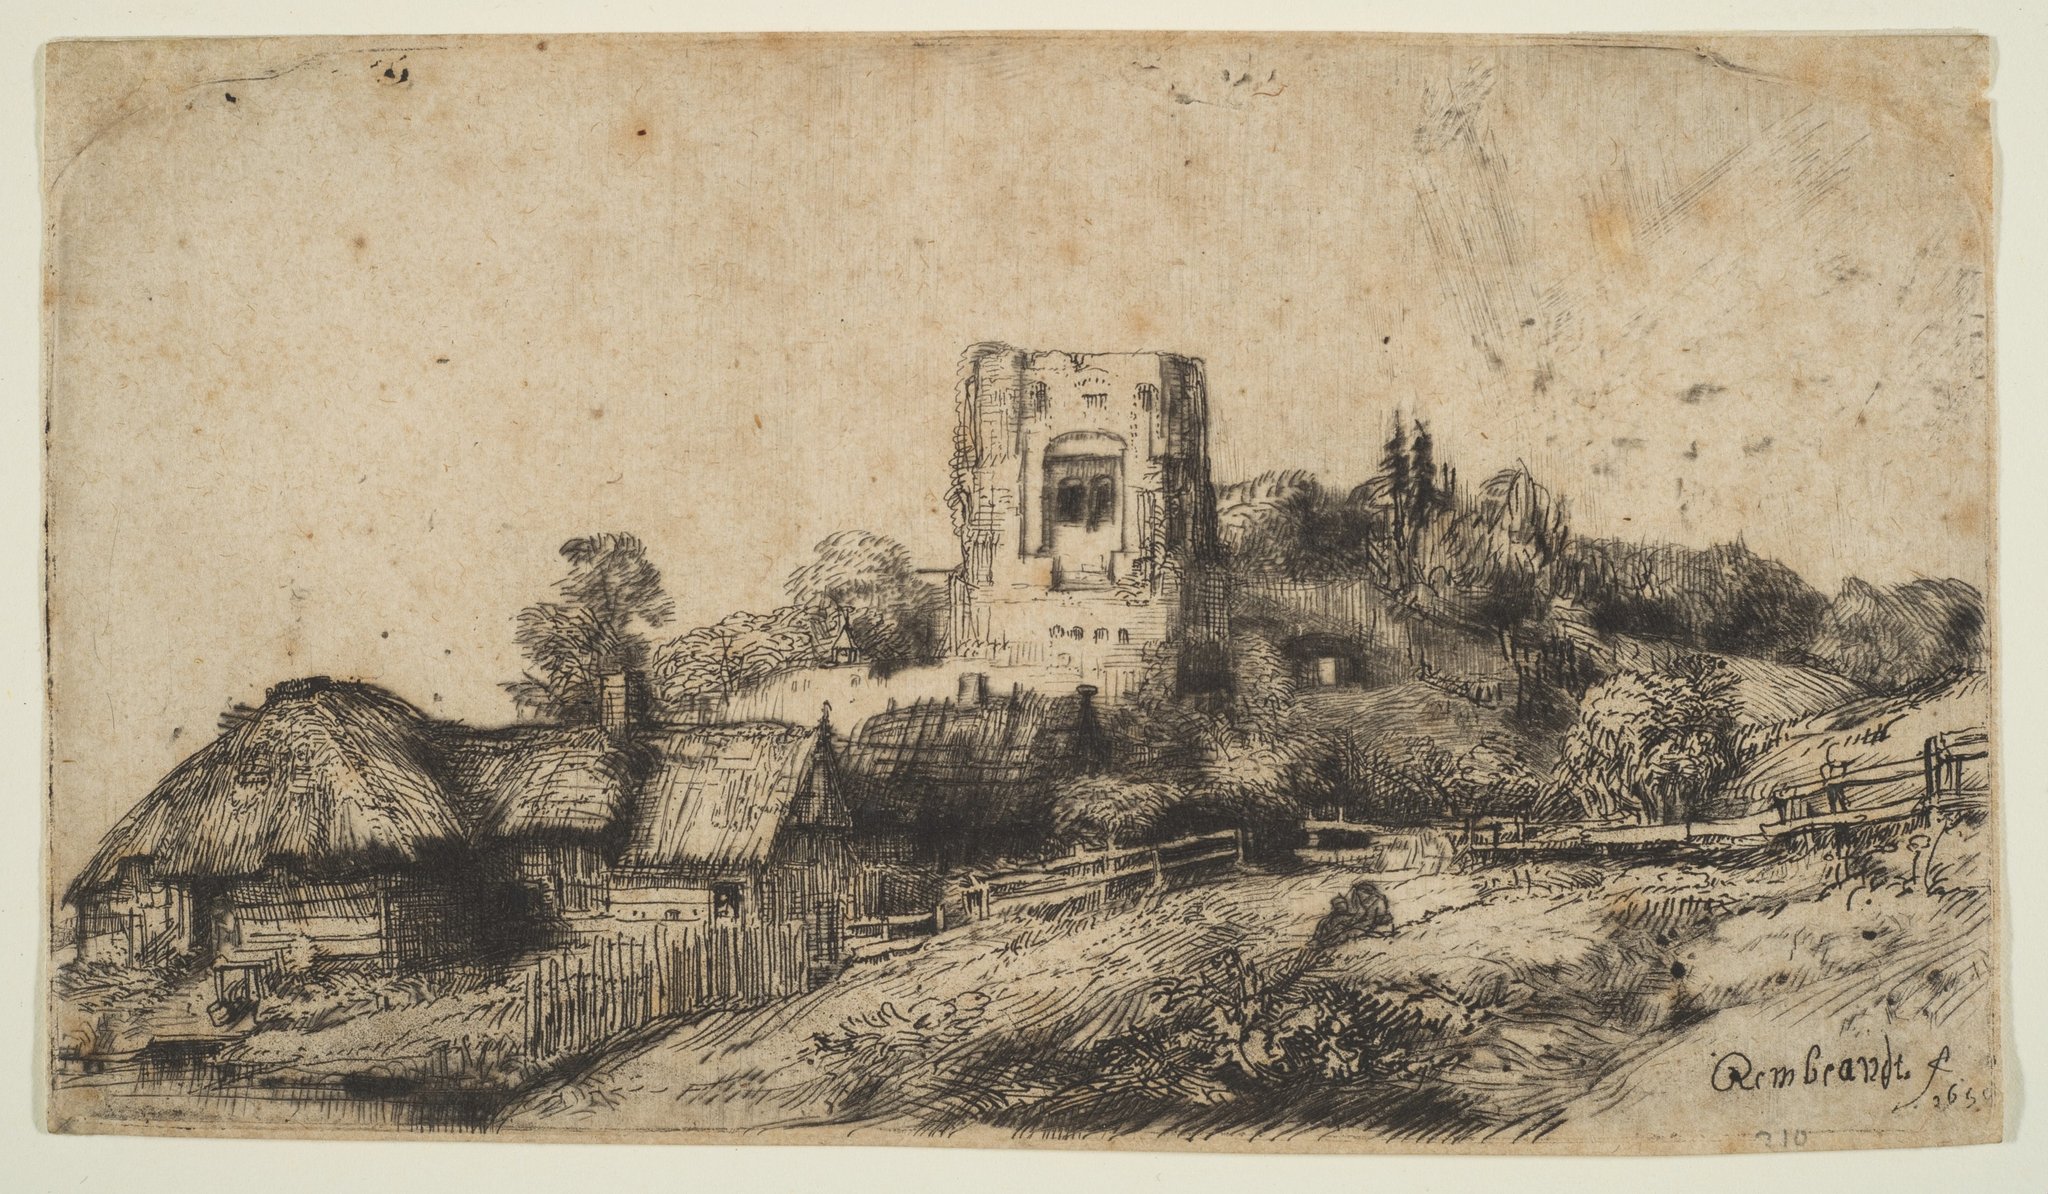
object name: print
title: Landscape with a Square Tower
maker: rembrandt van rijn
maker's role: artist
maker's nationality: dutch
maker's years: 1606-1669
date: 1650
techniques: drypoint, etching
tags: towers,landscapes,trees